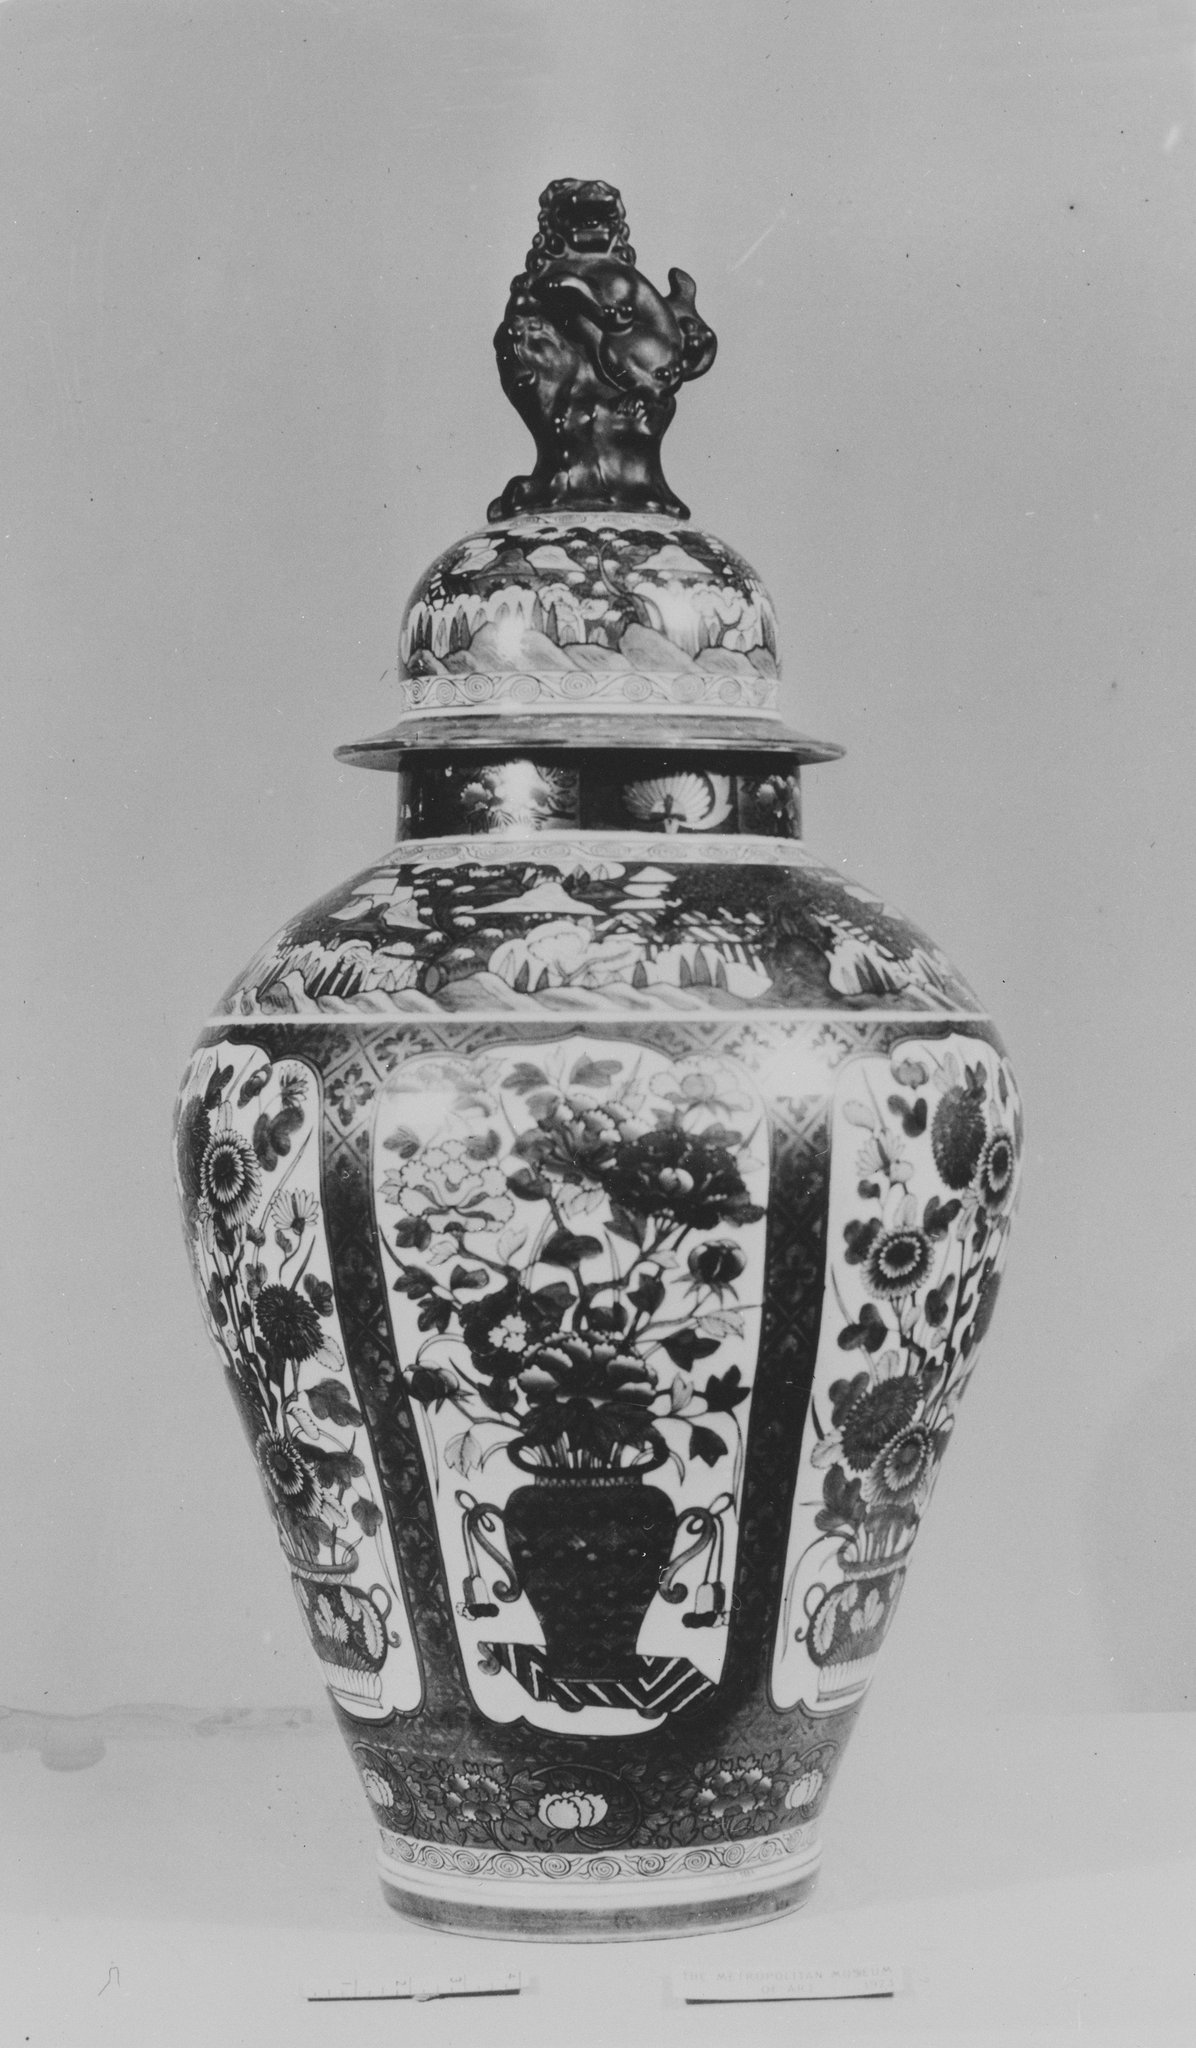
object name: vase with cover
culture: japanese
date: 1680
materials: enamel, gold, porcelain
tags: flowers